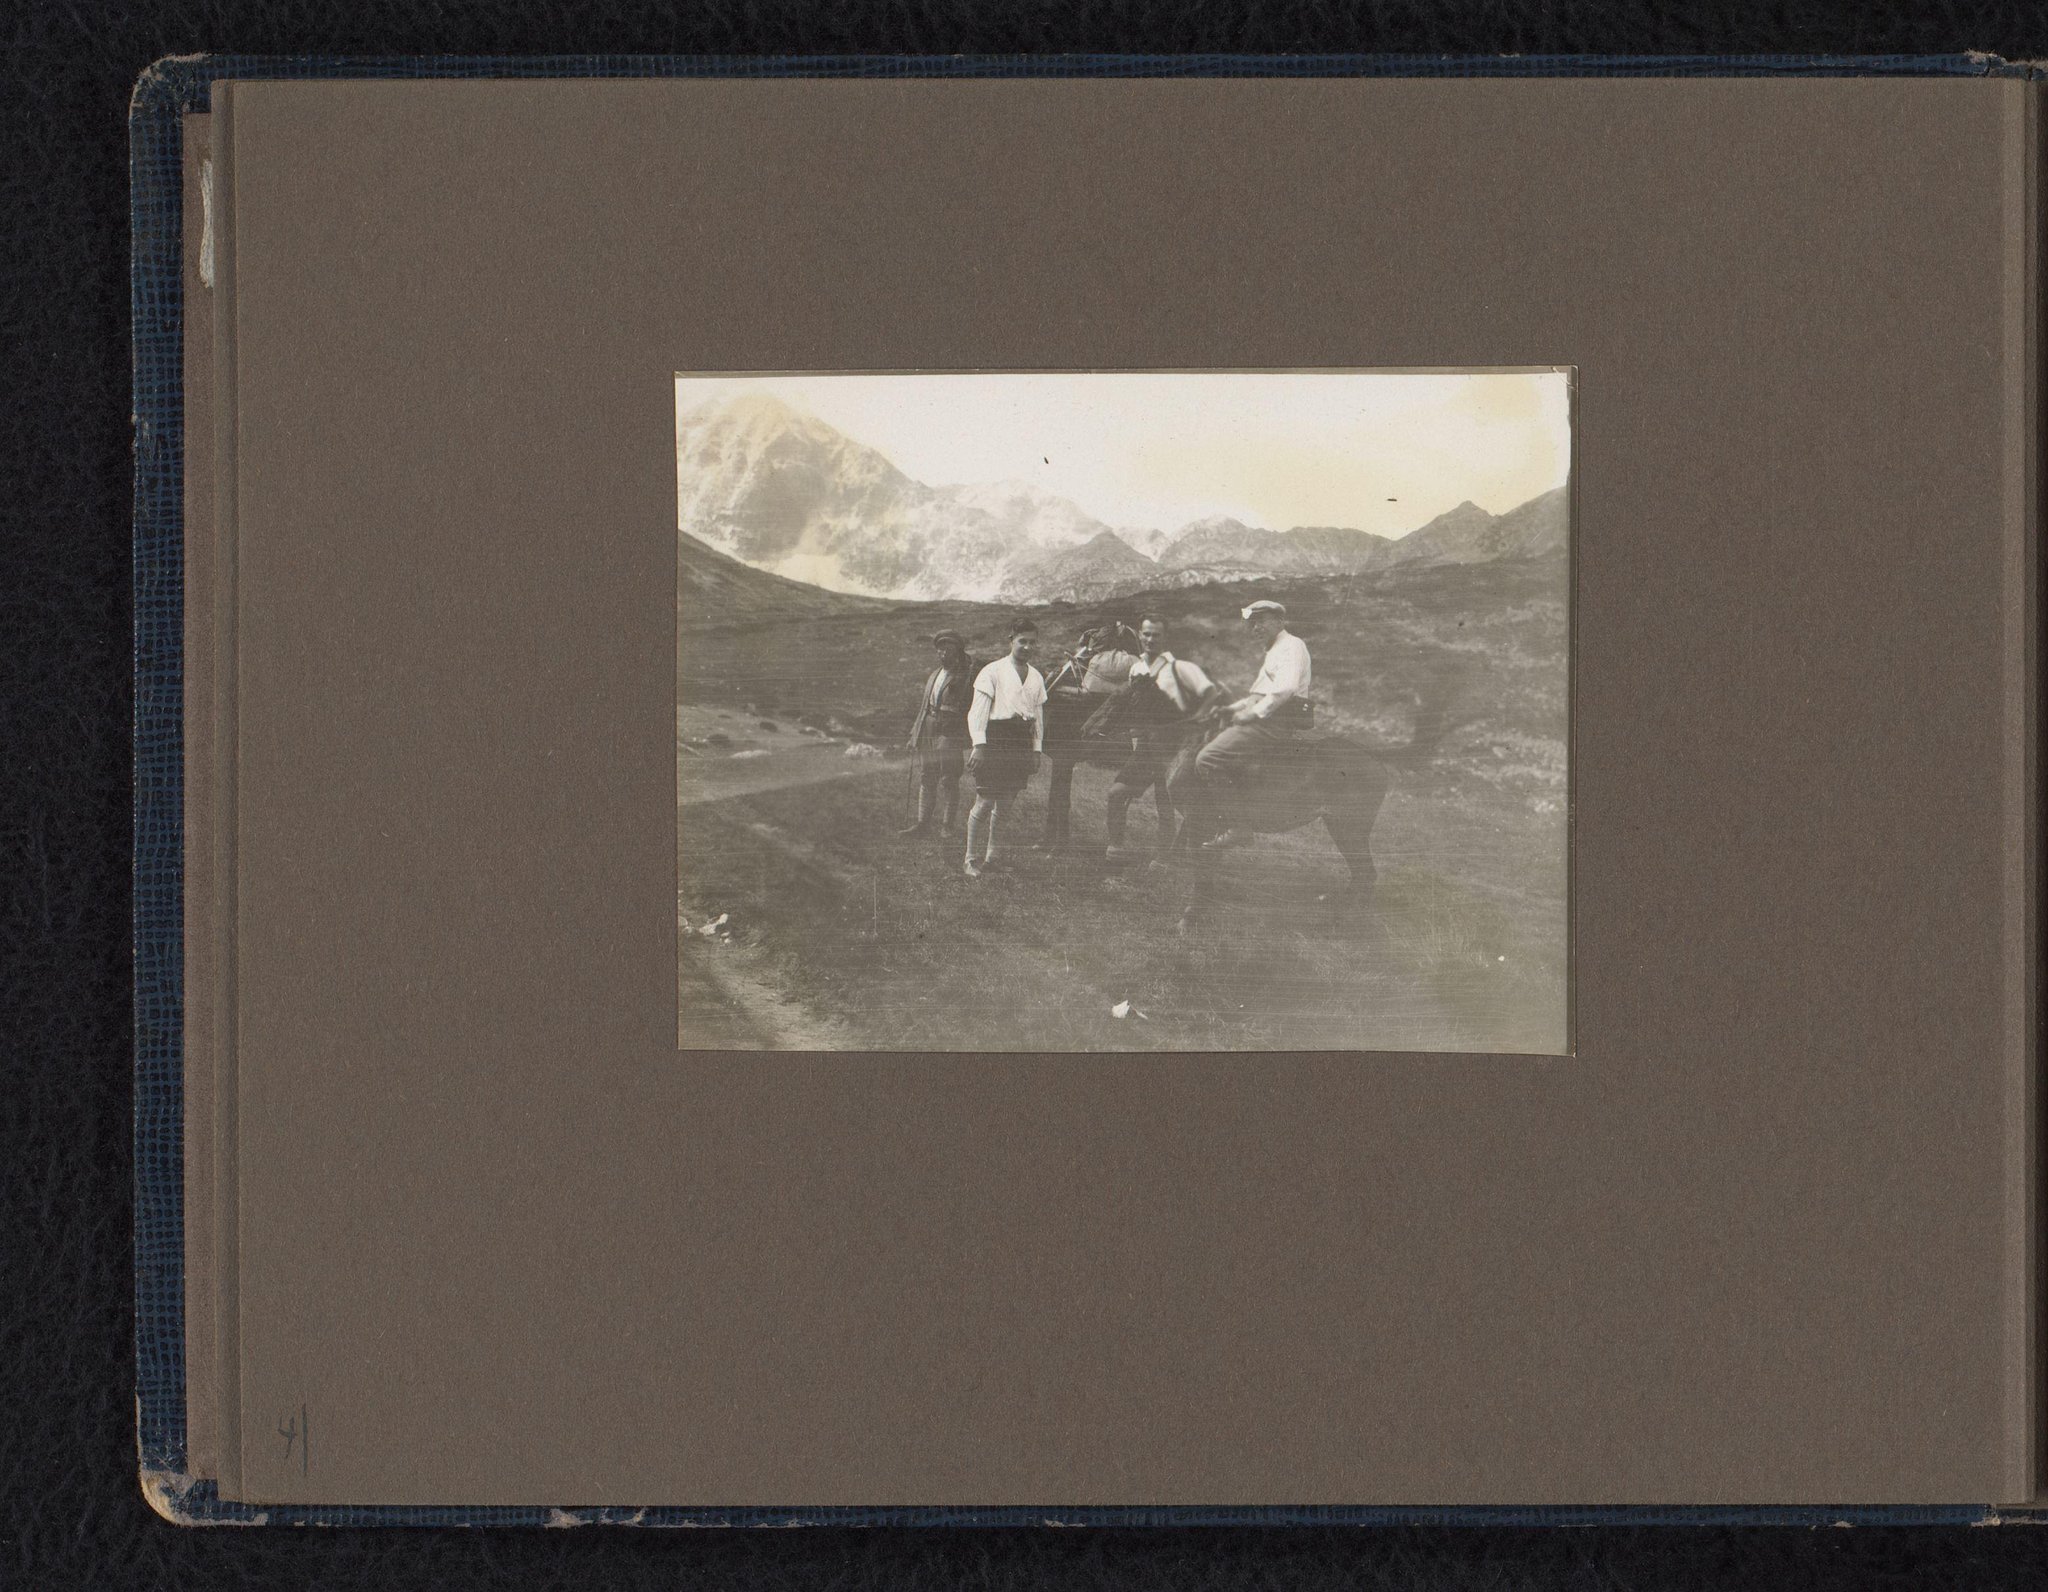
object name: album leaf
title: Mannen met een ezel in Bulgaars berglandschap, tijdens een rondreis van Eugen Wachenheimer en zijn echtgenote Else Wachenheimer-Moos door Bulgarije, 1922-1923, (mogelijk omgeving Sofia)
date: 1922-1923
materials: paper, photographic support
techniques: gelatin silver print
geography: bulgaria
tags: walking, hiking (recreation), mountain-range, snow peaks, mule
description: Albumblad bevat een foto van vier onbekende mannen. Uit album half formaat, blauw kunstlederen omslag met koordbinding.